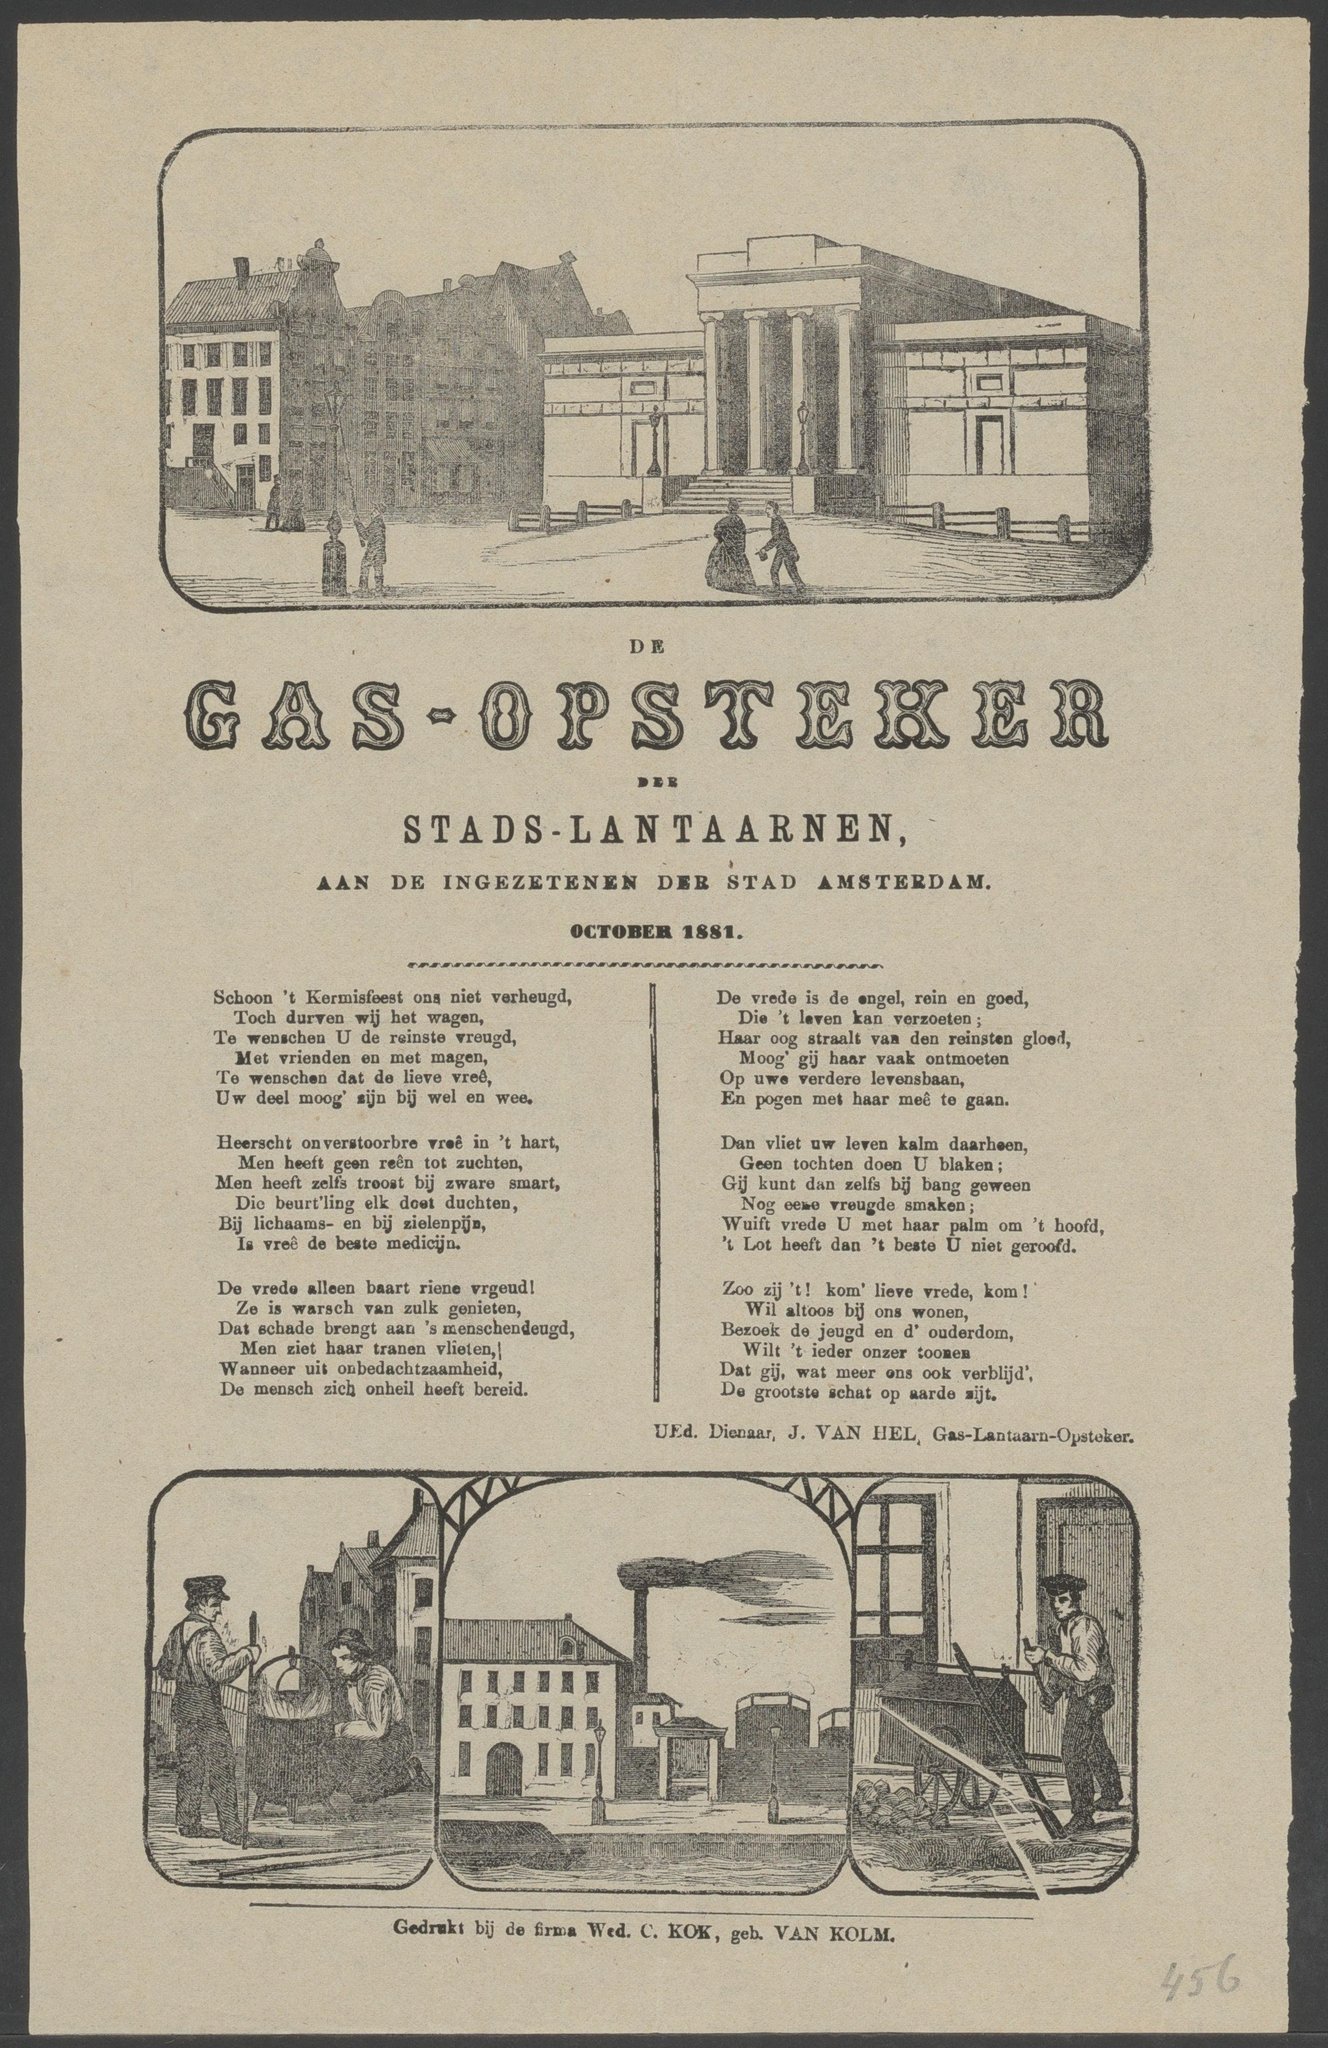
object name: print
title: De Gas-opsteker der stads-lantaarnen, aan de ingezetenen der stad Amsterdam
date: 1881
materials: paper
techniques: letterpress printing, engraving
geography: amsterdam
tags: gas-lamp, gas supply, digging (industrial process), street lighting, amsterdam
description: Kermiswens van de Amsterdamse gaslantaarnopstekers voor het jaar 1881. Centraal een vers in twee kolommen. Bovenaan de Dam met de beurs van Zocher te Amsterdam. Onderaan de Hollandsche Gasfabriek en twee gasfitters aan het werk. Van de gaslantaarnopsteker: J. van Hel. Onderwerpsrubrieken binnen de Atlas Zeden en Gewoonten: Zeden en gewoonten in engeren zin, Volksleven, Volksbladen, Nieuwjaars- en Kerstwenschen, Amsterdam.